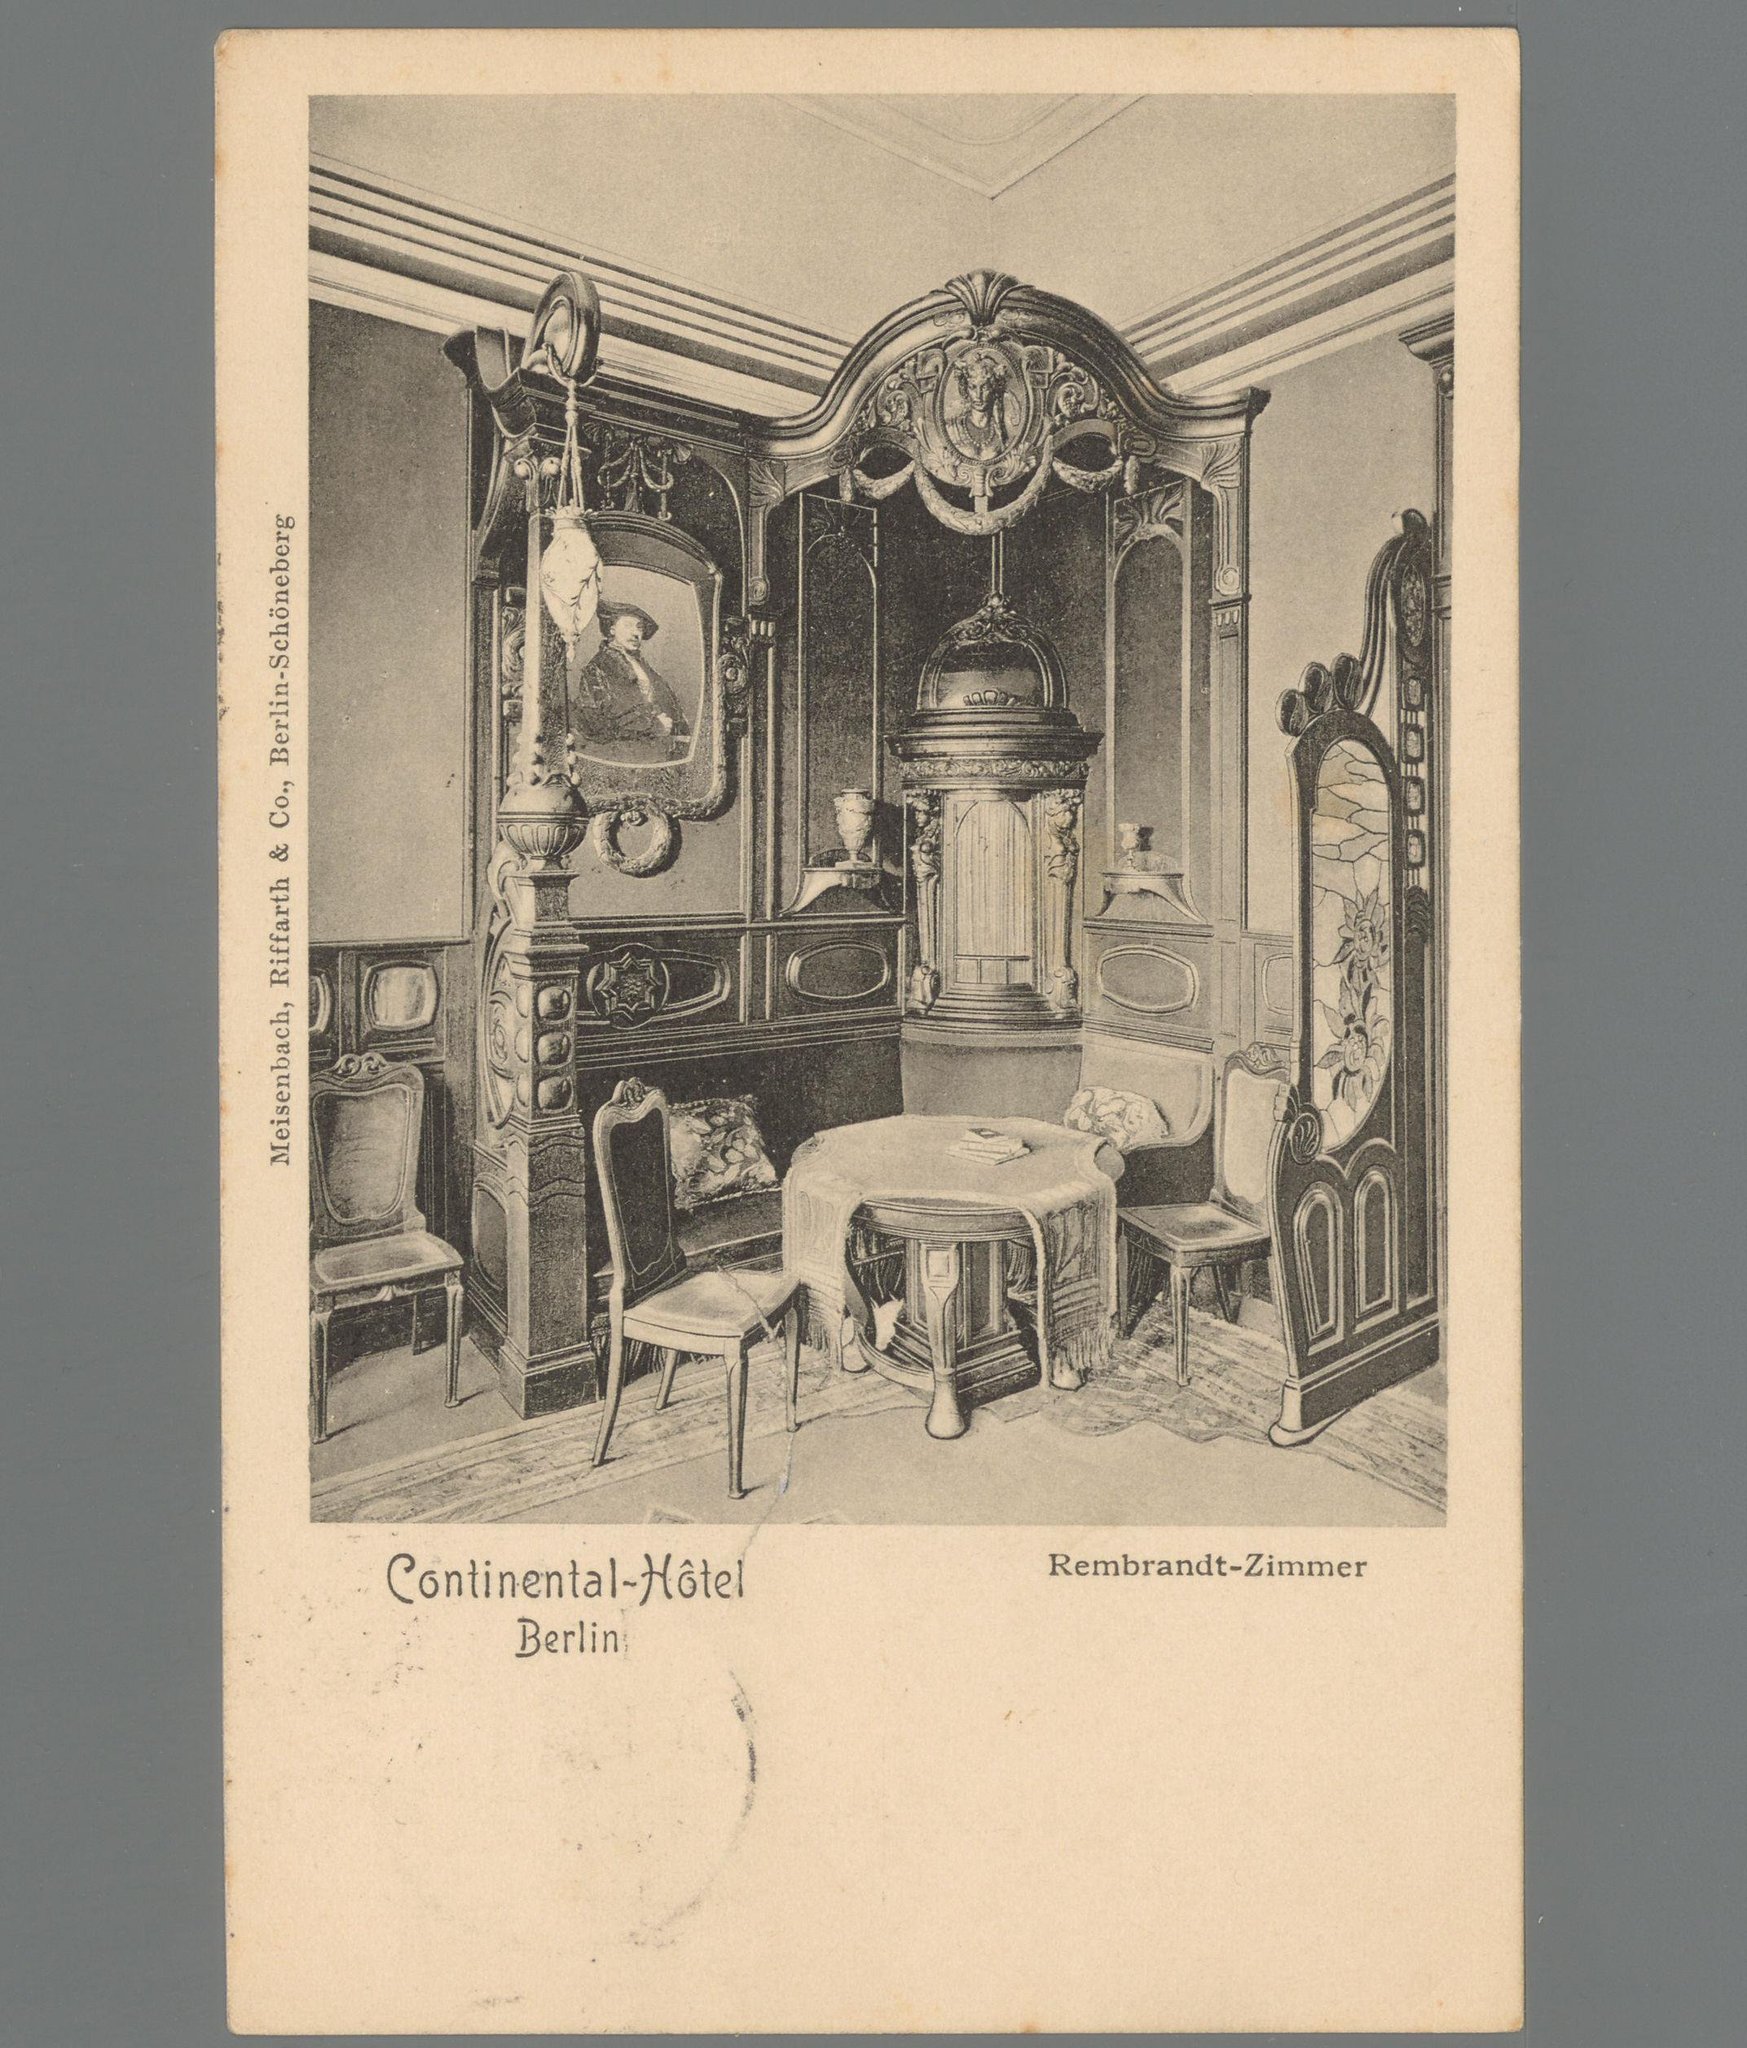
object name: ansichtkaart, prentbriefkaart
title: Continental-Hôtel Berlin. Rembrandt-Zimmer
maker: Anonymous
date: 1885-1905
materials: cardboard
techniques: photograph, writing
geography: schöneberg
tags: hotel, hostelry, inn, berlin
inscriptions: postage stamp